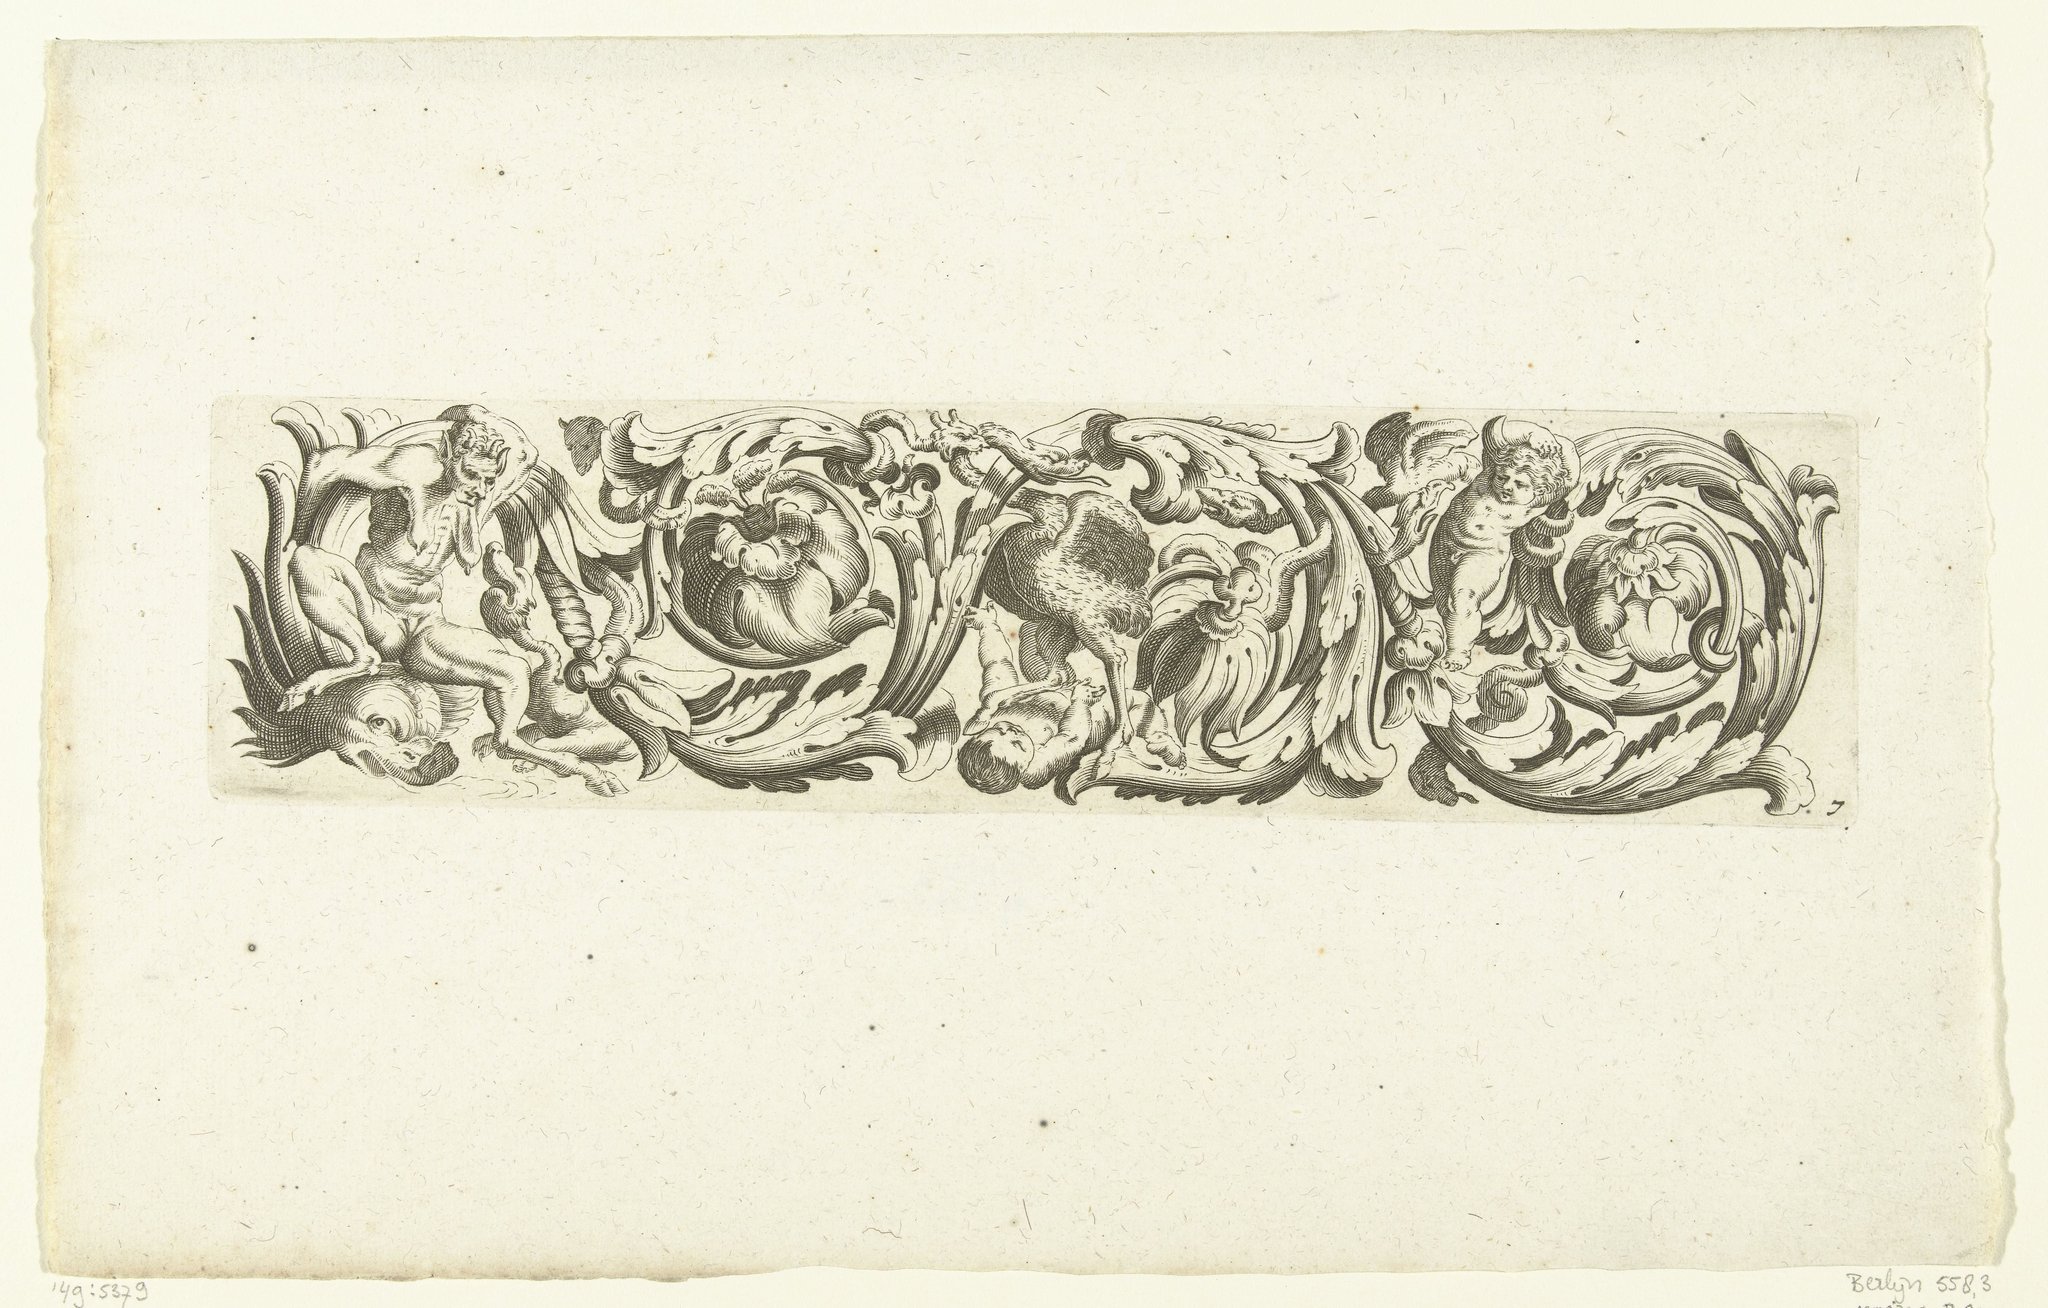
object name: ornament print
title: Bladrank met oude vrouw op dolfijn links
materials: paper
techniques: engraving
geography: amsterdam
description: Blad 7 uit serie met Nederlandse tegenzijdige verkleinde kopieën van de serie Disegnii Varii Di Polifilo Zancarli.